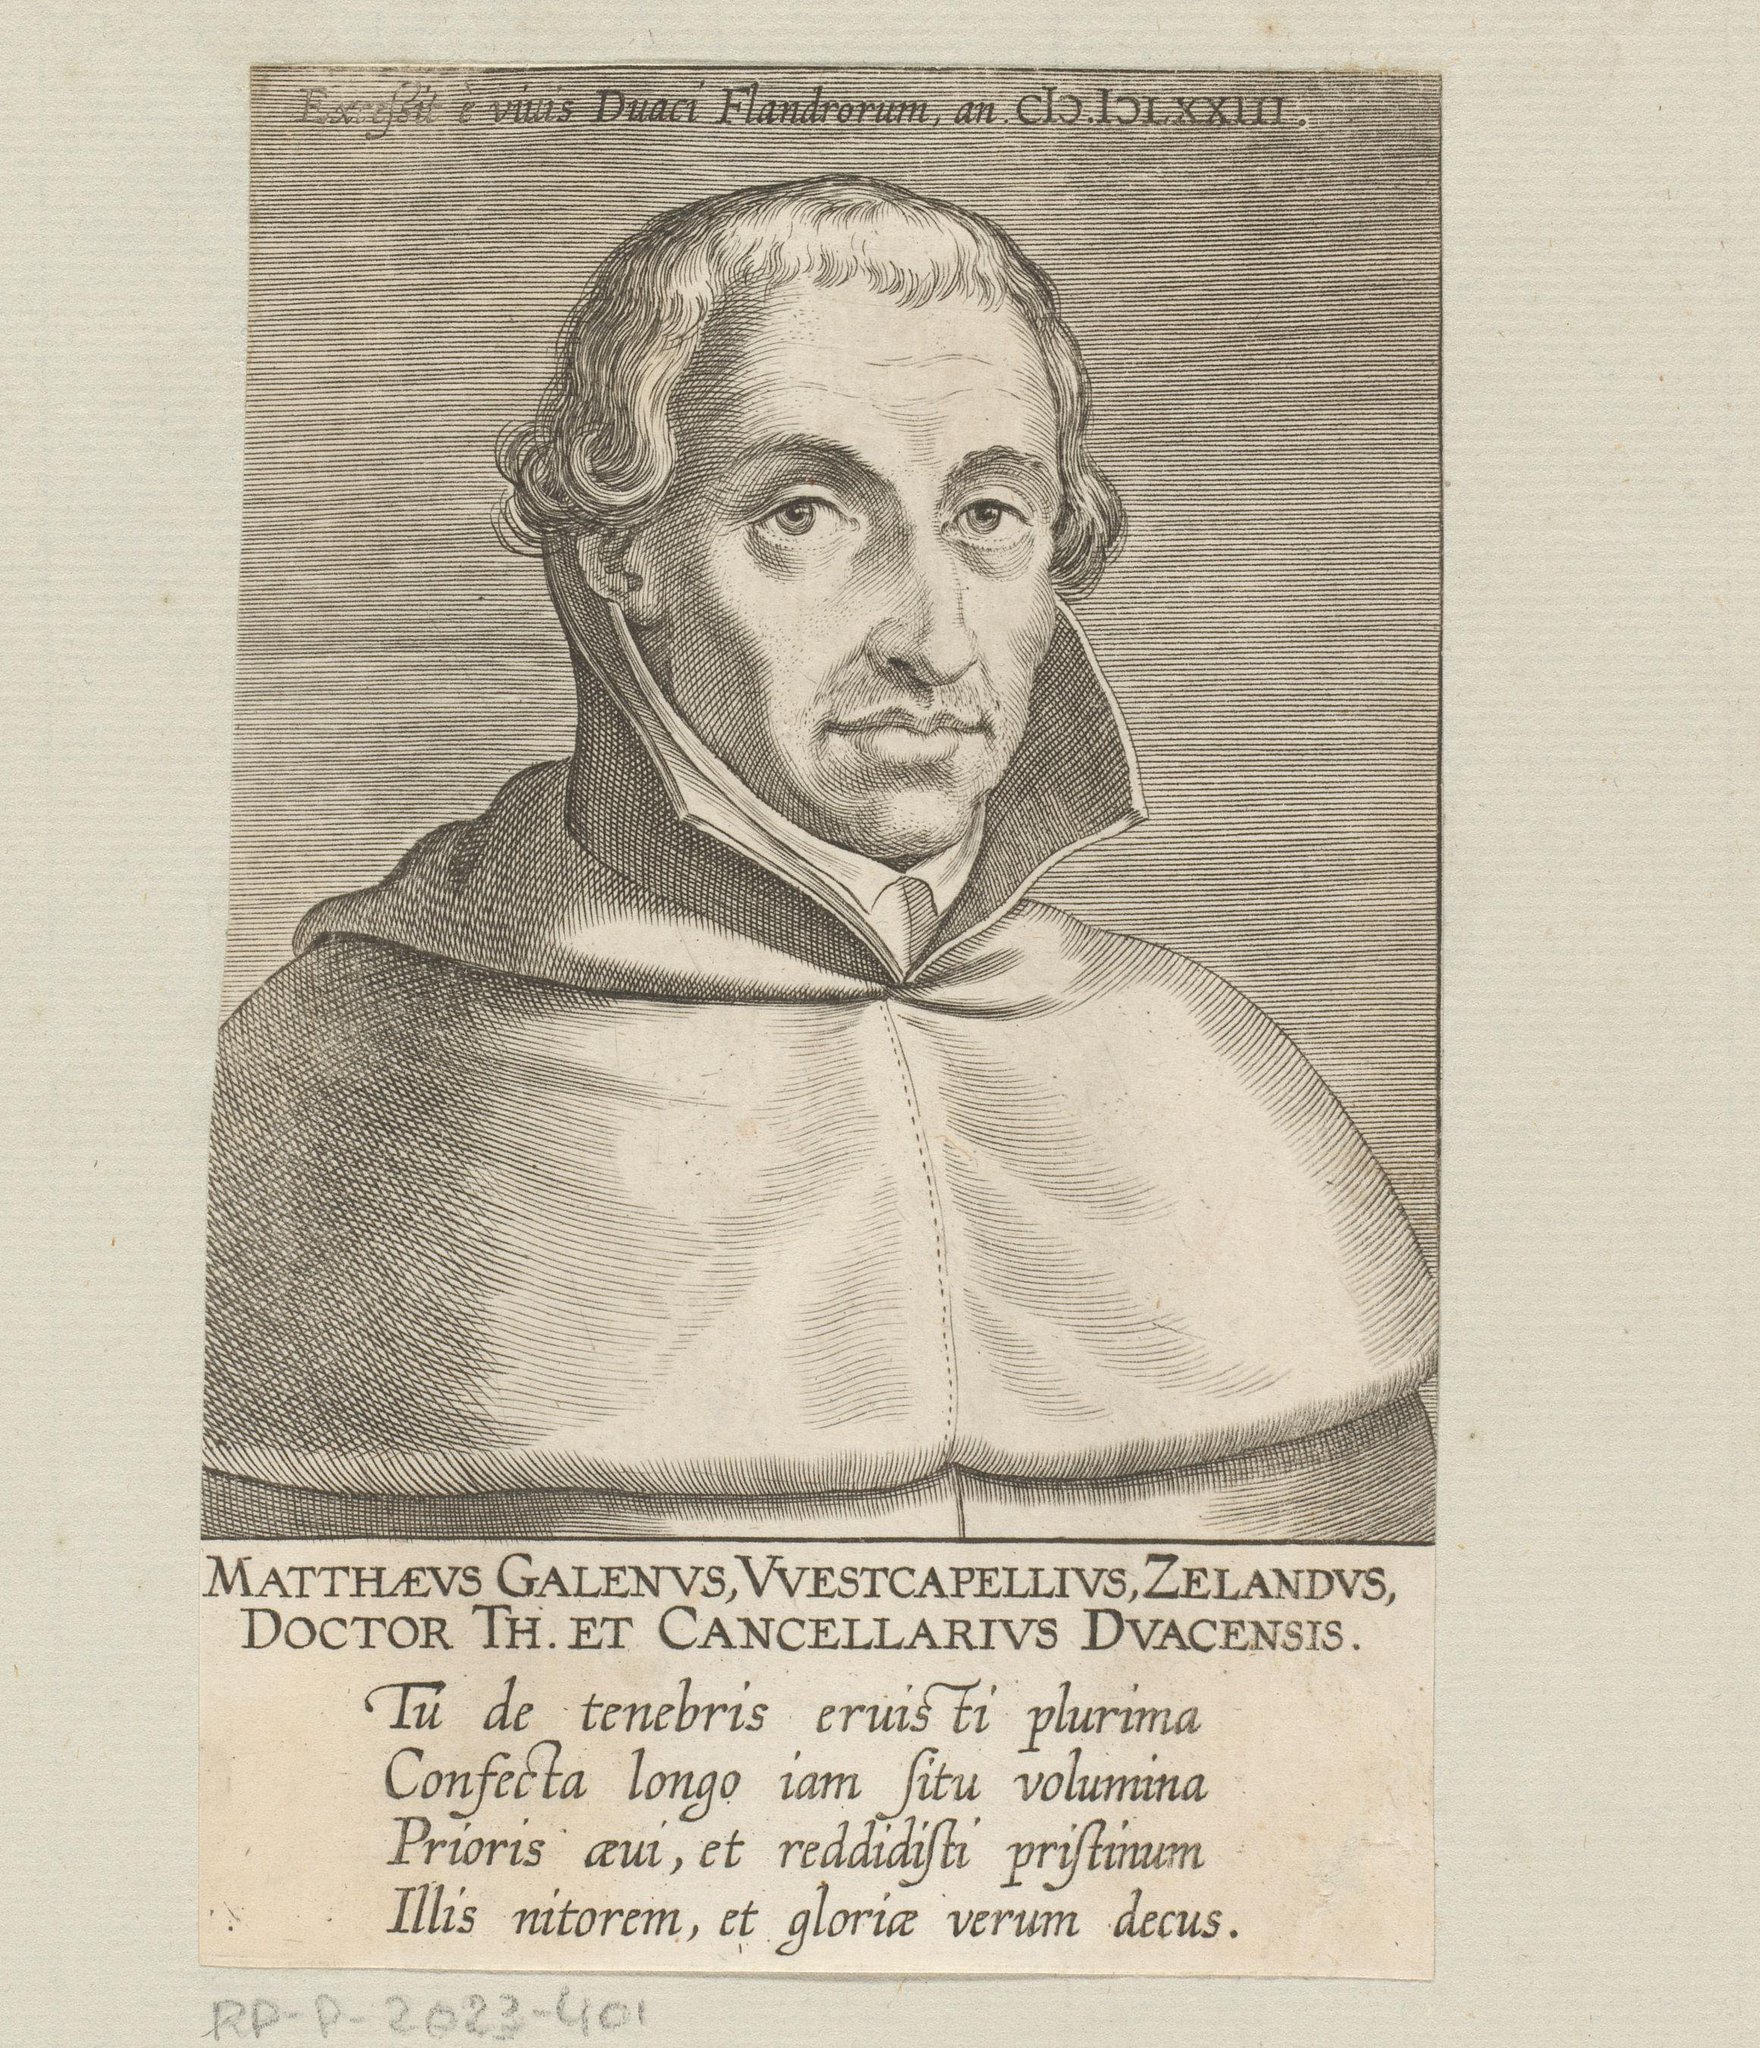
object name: print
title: Bibliotheca Belgica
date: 1604-1608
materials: paper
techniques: engraving, snipping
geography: antwerp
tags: historical persons, professor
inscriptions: inscription: ‘n. 1528 uit Foppens, p. 865, 199 (?)’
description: Prent waarschijnlijk uit: Foppens, Johannes Franciscus. Bibliotheca Belgica (...). Brussel: Peter Foppens, 1739.